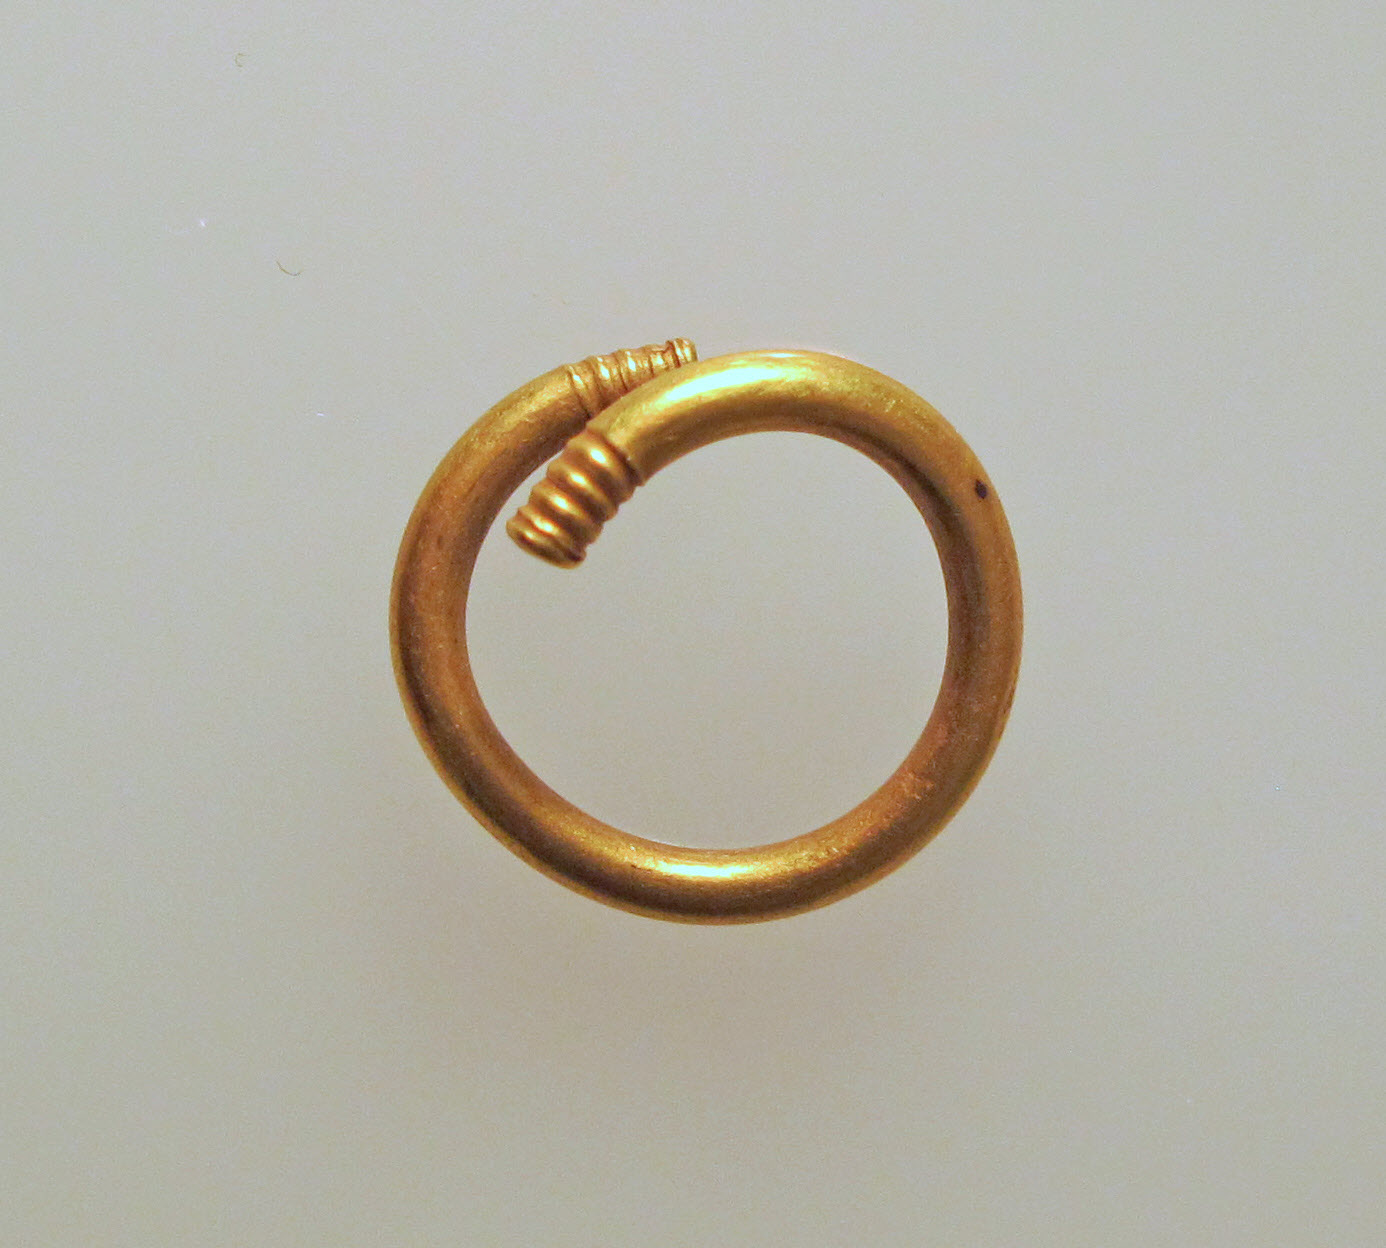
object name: spiral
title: Spirals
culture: cypriot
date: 3900 BCE-100 CE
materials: gold